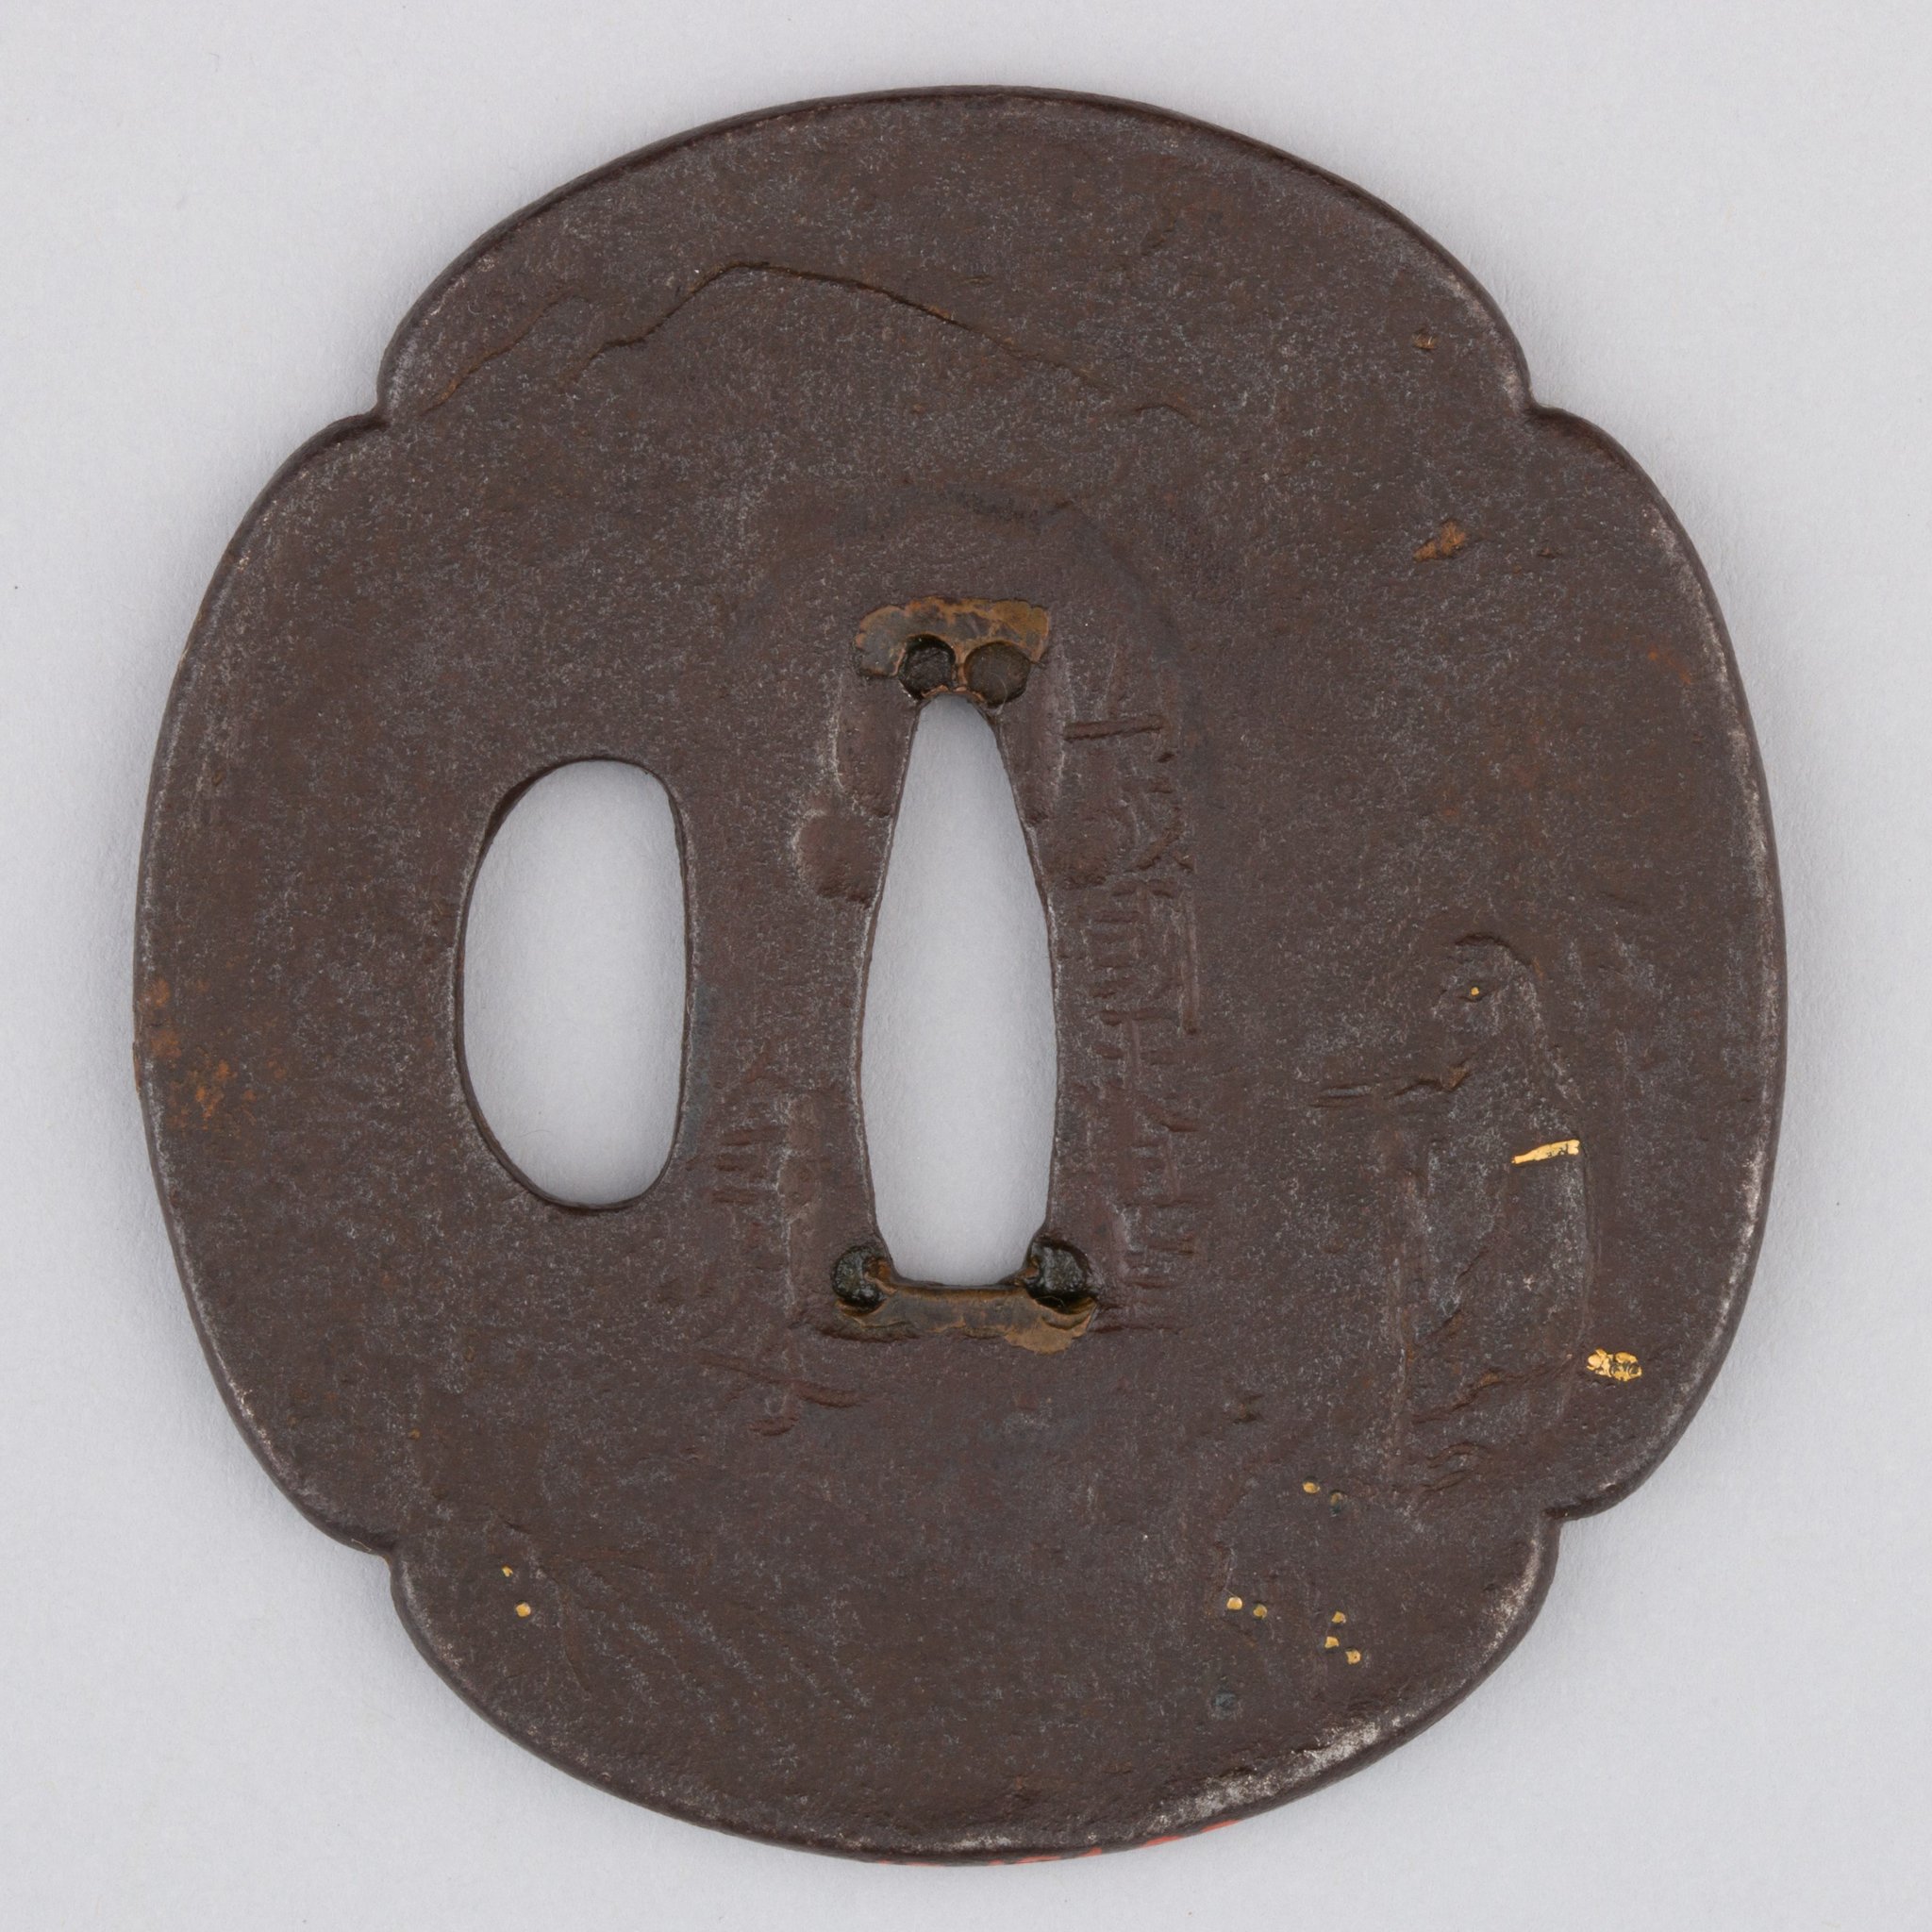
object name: sword guard tsuba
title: Sword Guard (Tsuba)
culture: japanese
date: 1615-1868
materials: copper, iron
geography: japan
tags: men